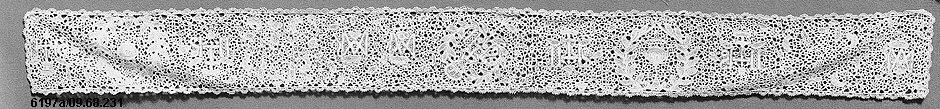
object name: border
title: Lace border with emblems of the Passion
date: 1601-1700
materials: linen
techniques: lace